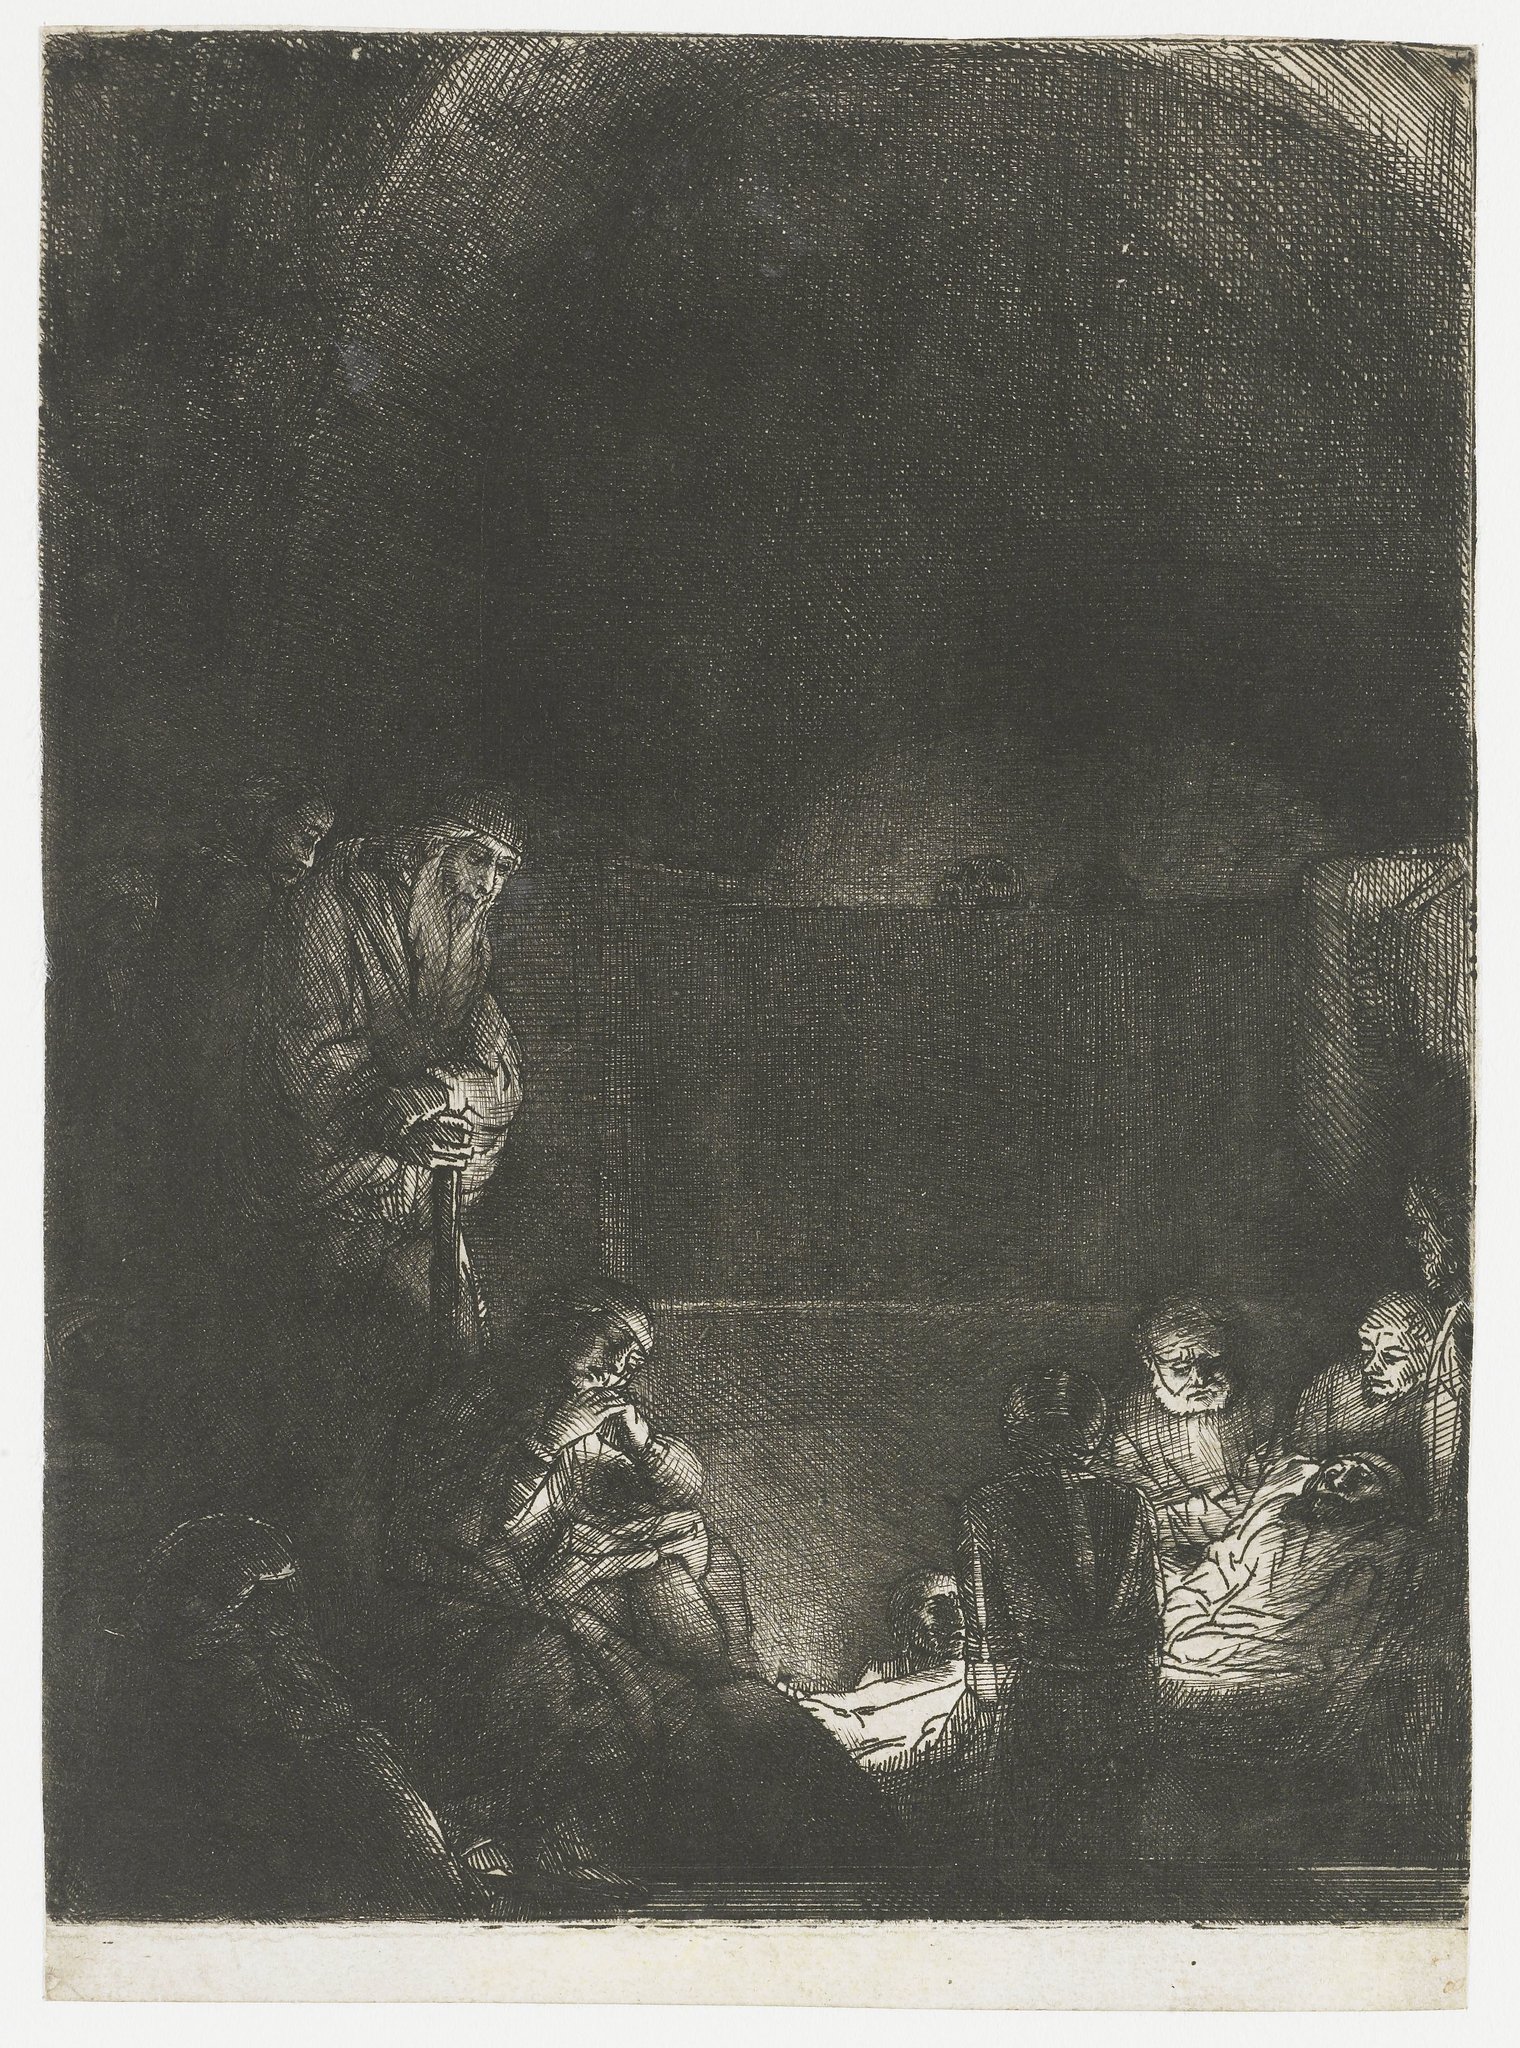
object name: print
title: The Entombment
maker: rembrandt van rijn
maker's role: draughtsman, painter, print maker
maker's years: 1606-1669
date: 1654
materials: paper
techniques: drypoint, etching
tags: christ's entombment (possibly by angels)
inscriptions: mark: Lugt 2228